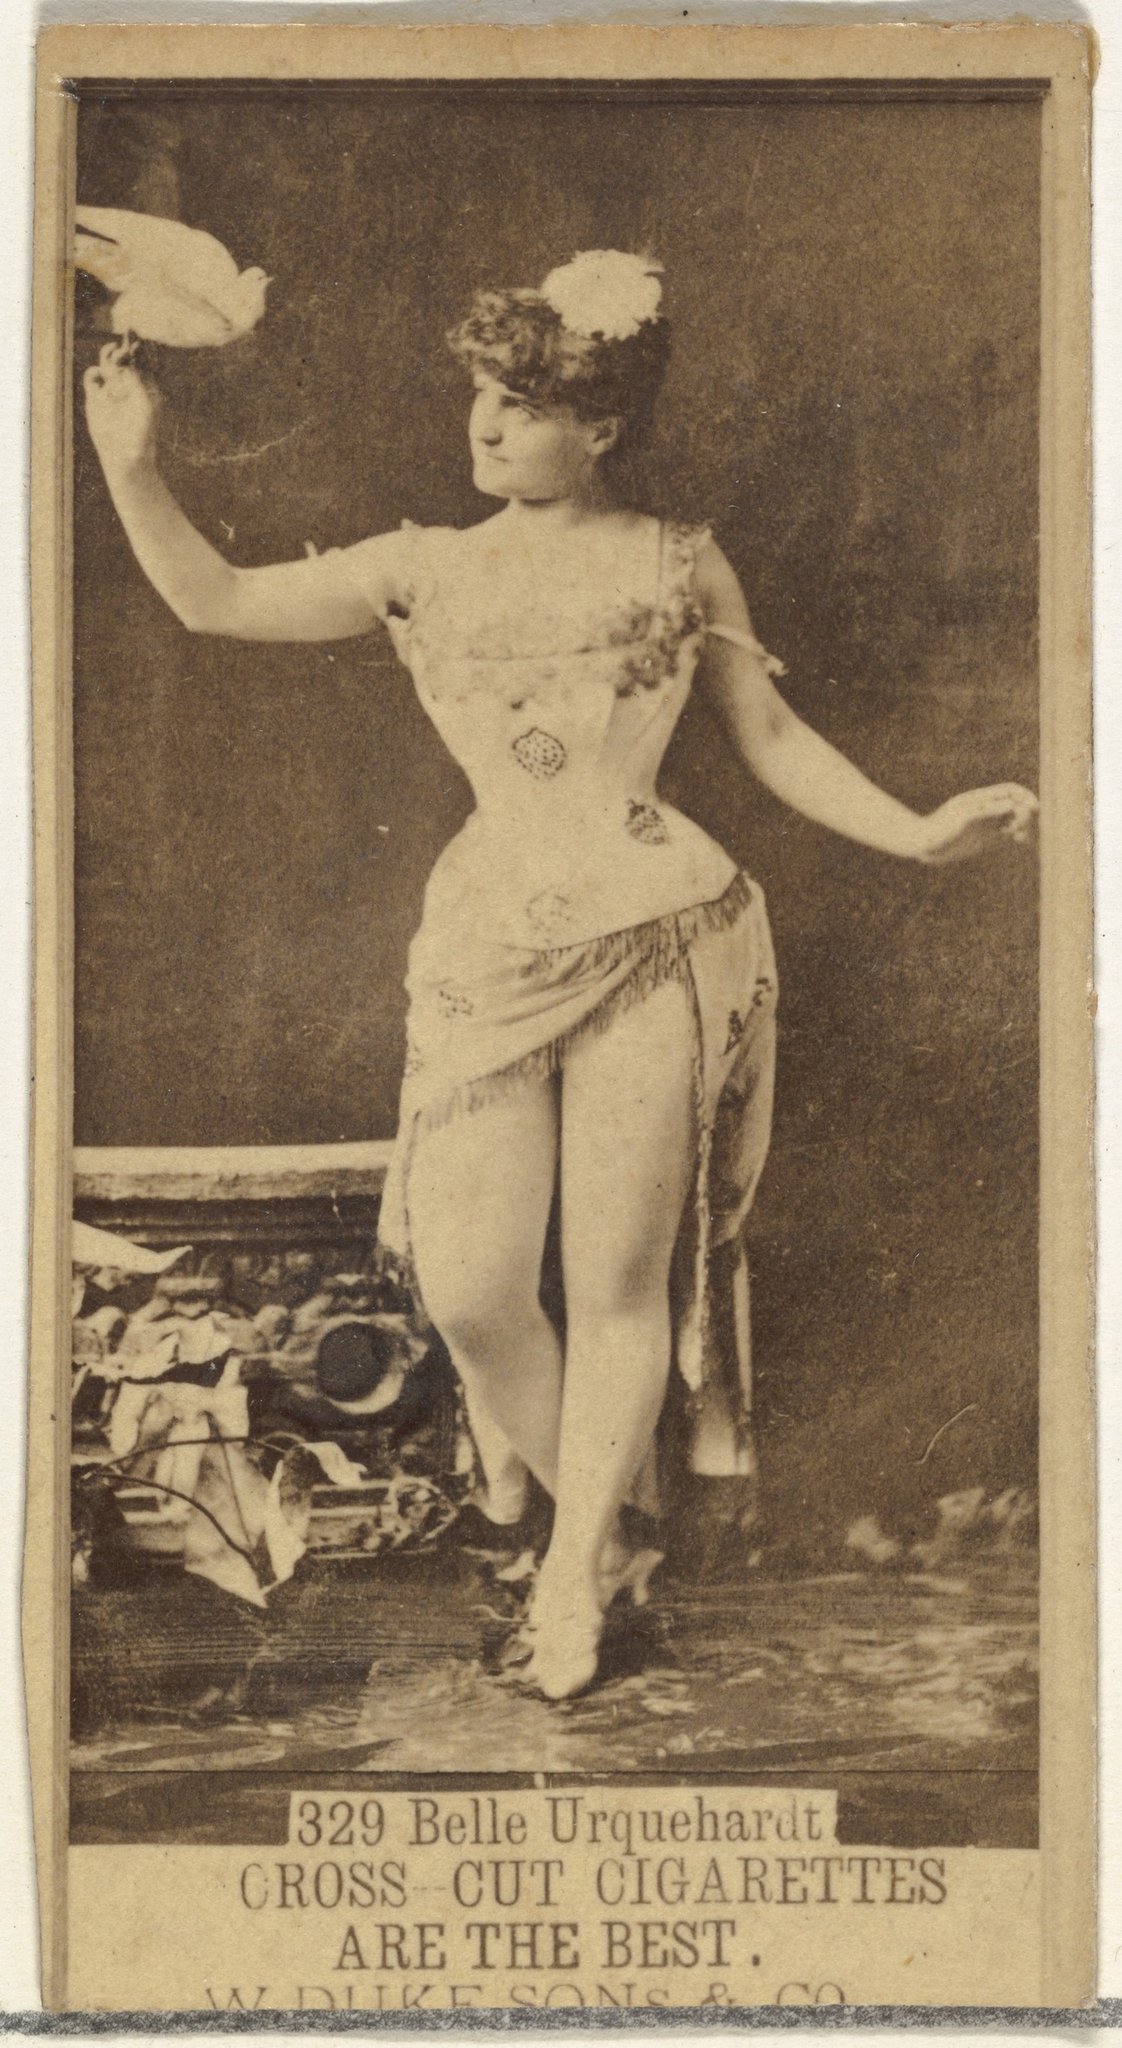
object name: photograph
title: Card Number 329, Belle Urquehardt, from the Actors and Actresses series (N145-3) issued by Duke Sons & Co. to promote Cross Cut Cigarettes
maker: w. duke, sons & co.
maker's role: publisher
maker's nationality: american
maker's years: 1870-1920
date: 1880-1889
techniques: albumen silver print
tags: women,actresses